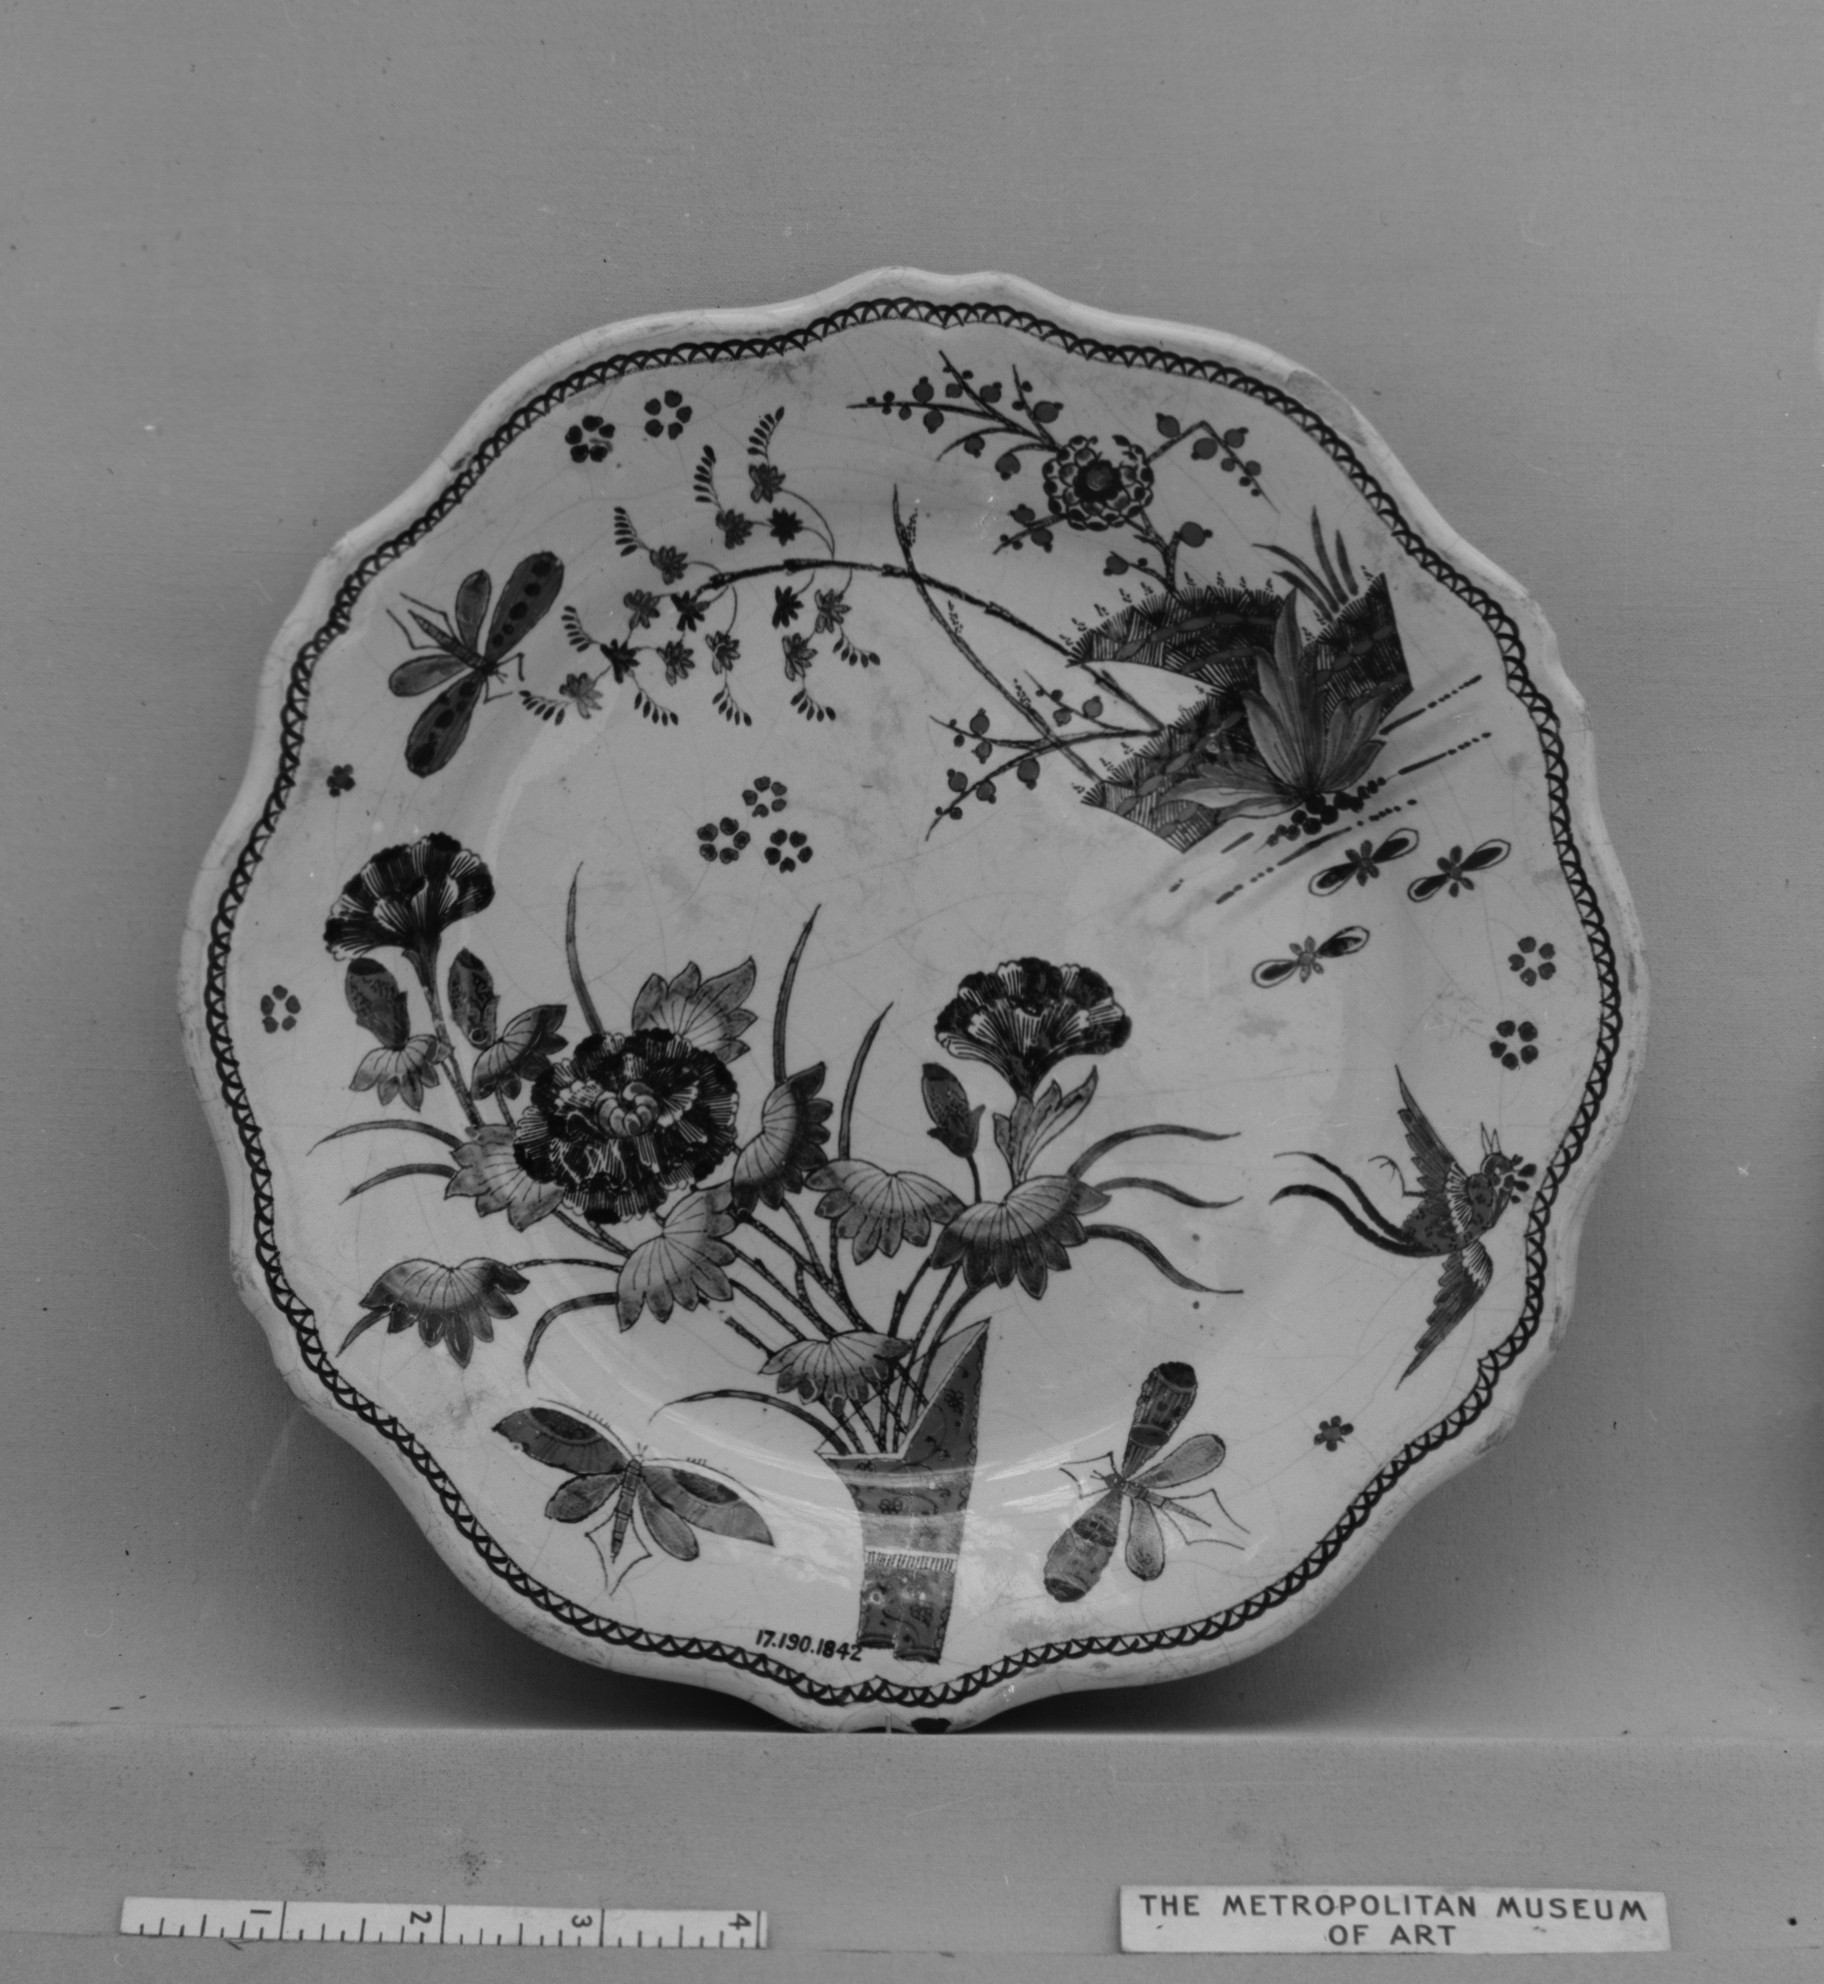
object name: plate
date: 1720-1750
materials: faience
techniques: glazing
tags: birds,insects,flowers